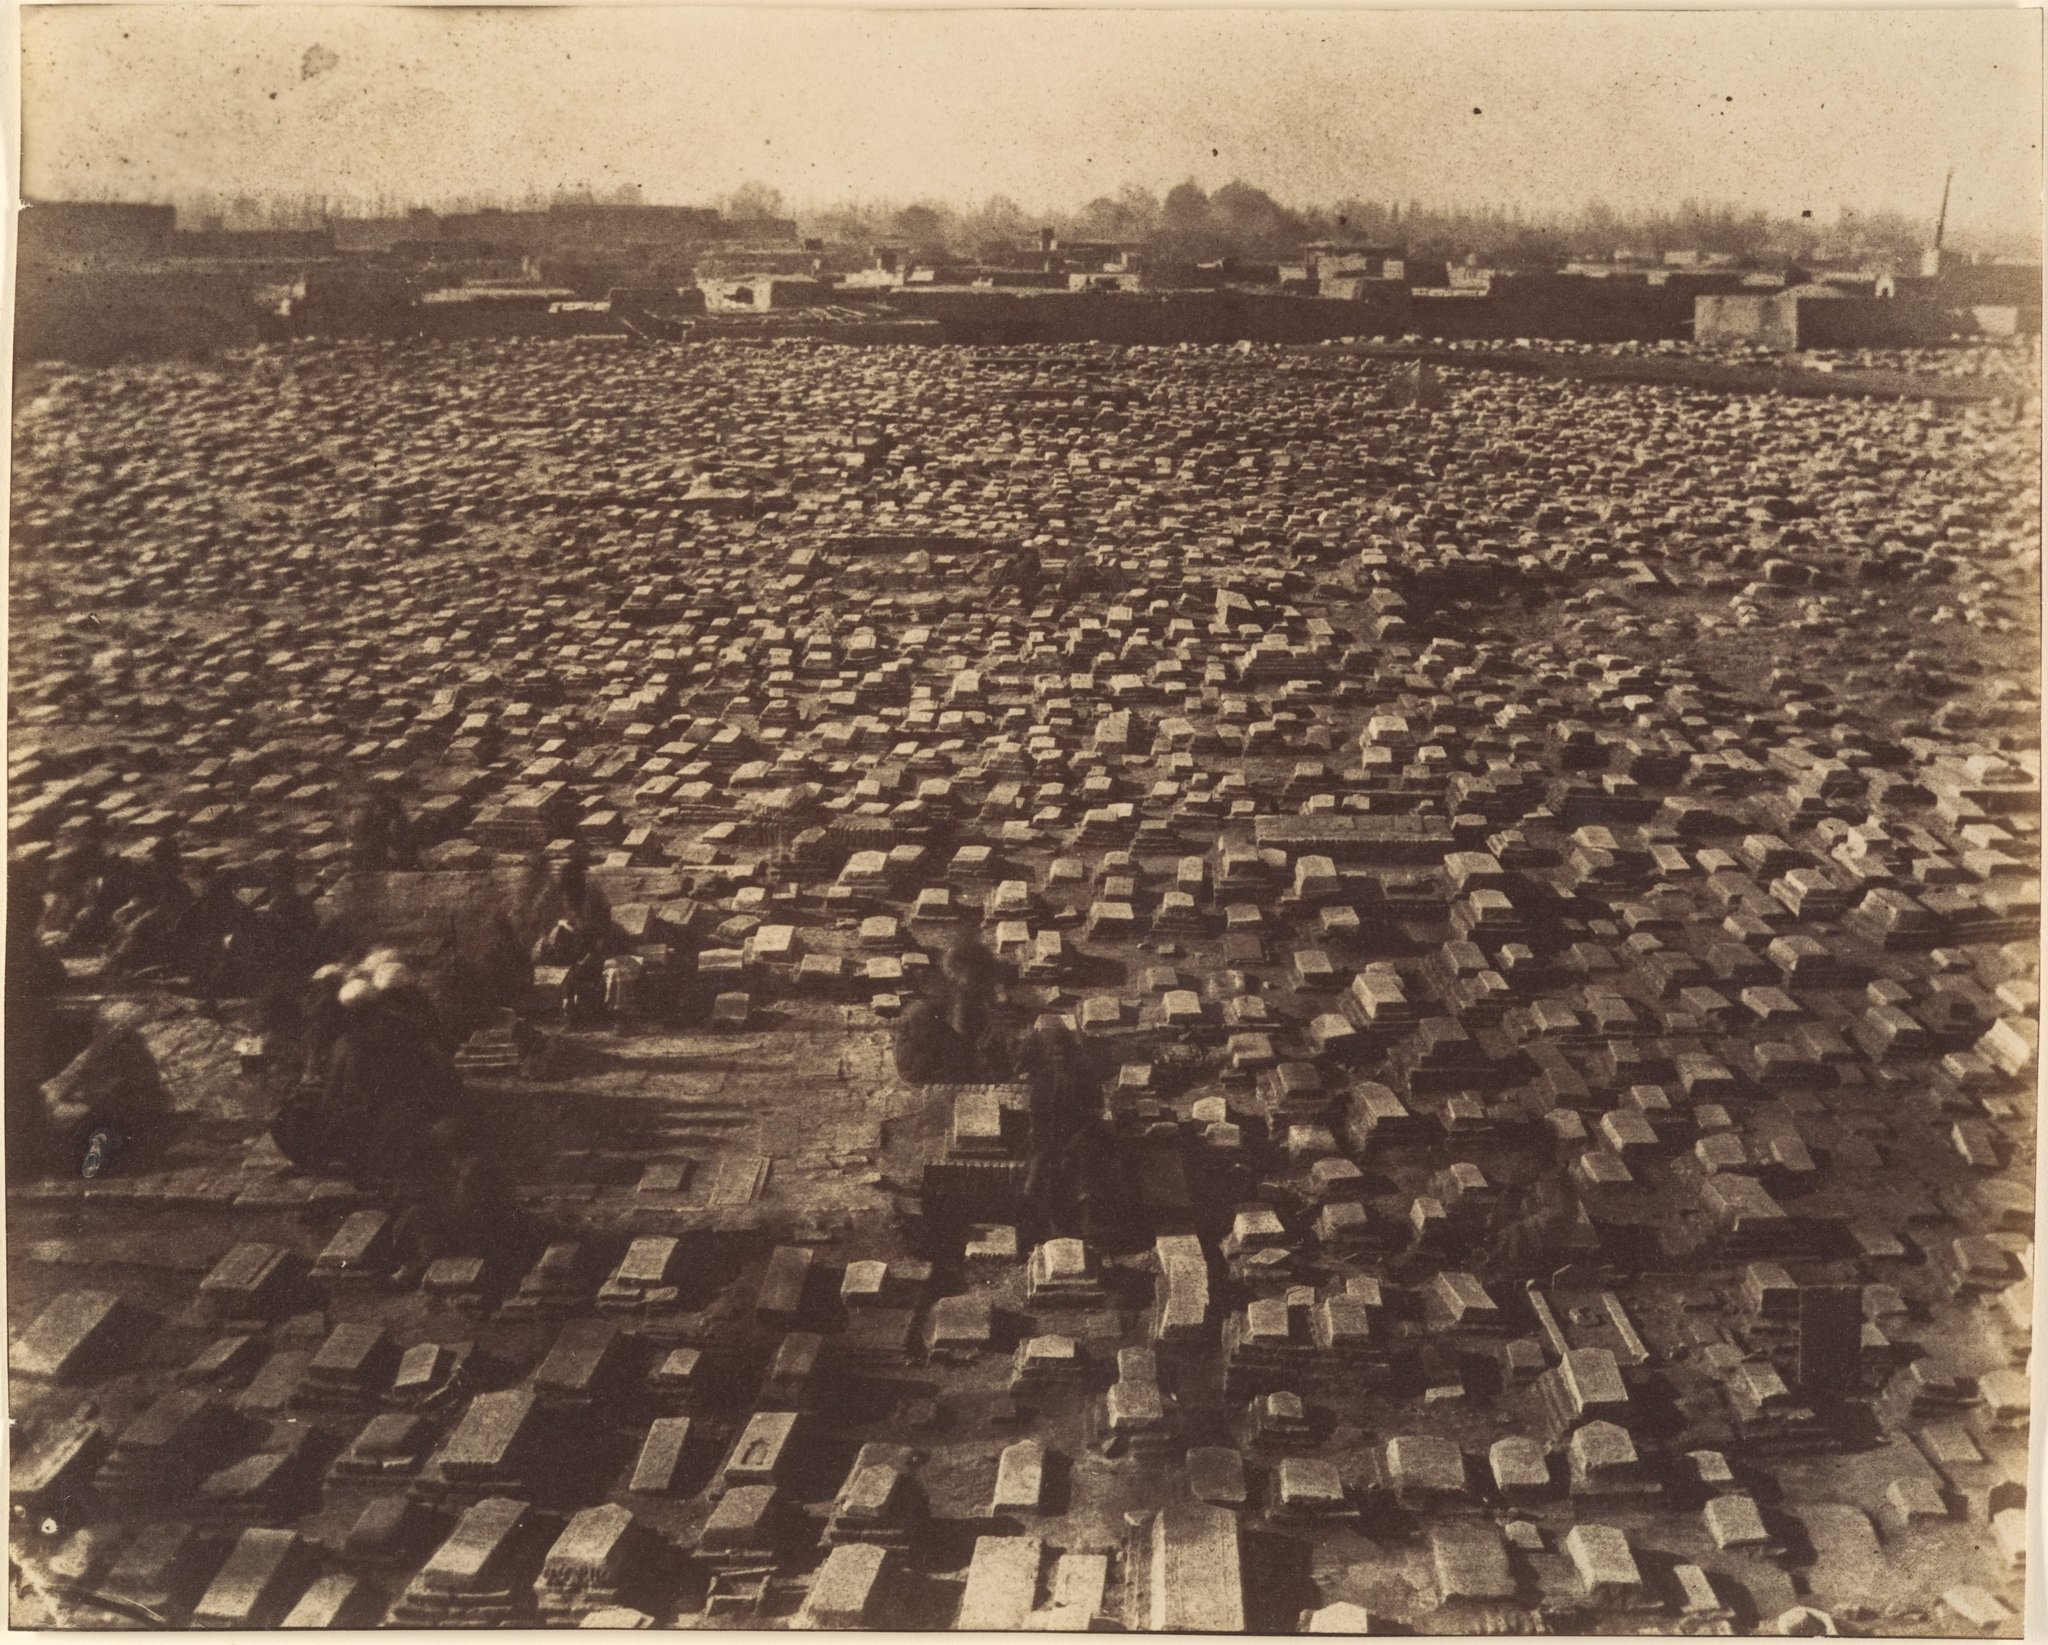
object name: photograph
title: [Cemetry of MESHED]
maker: luigi pesce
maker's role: artist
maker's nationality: italian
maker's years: 1818-1891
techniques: albumen silver print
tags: cemeteries